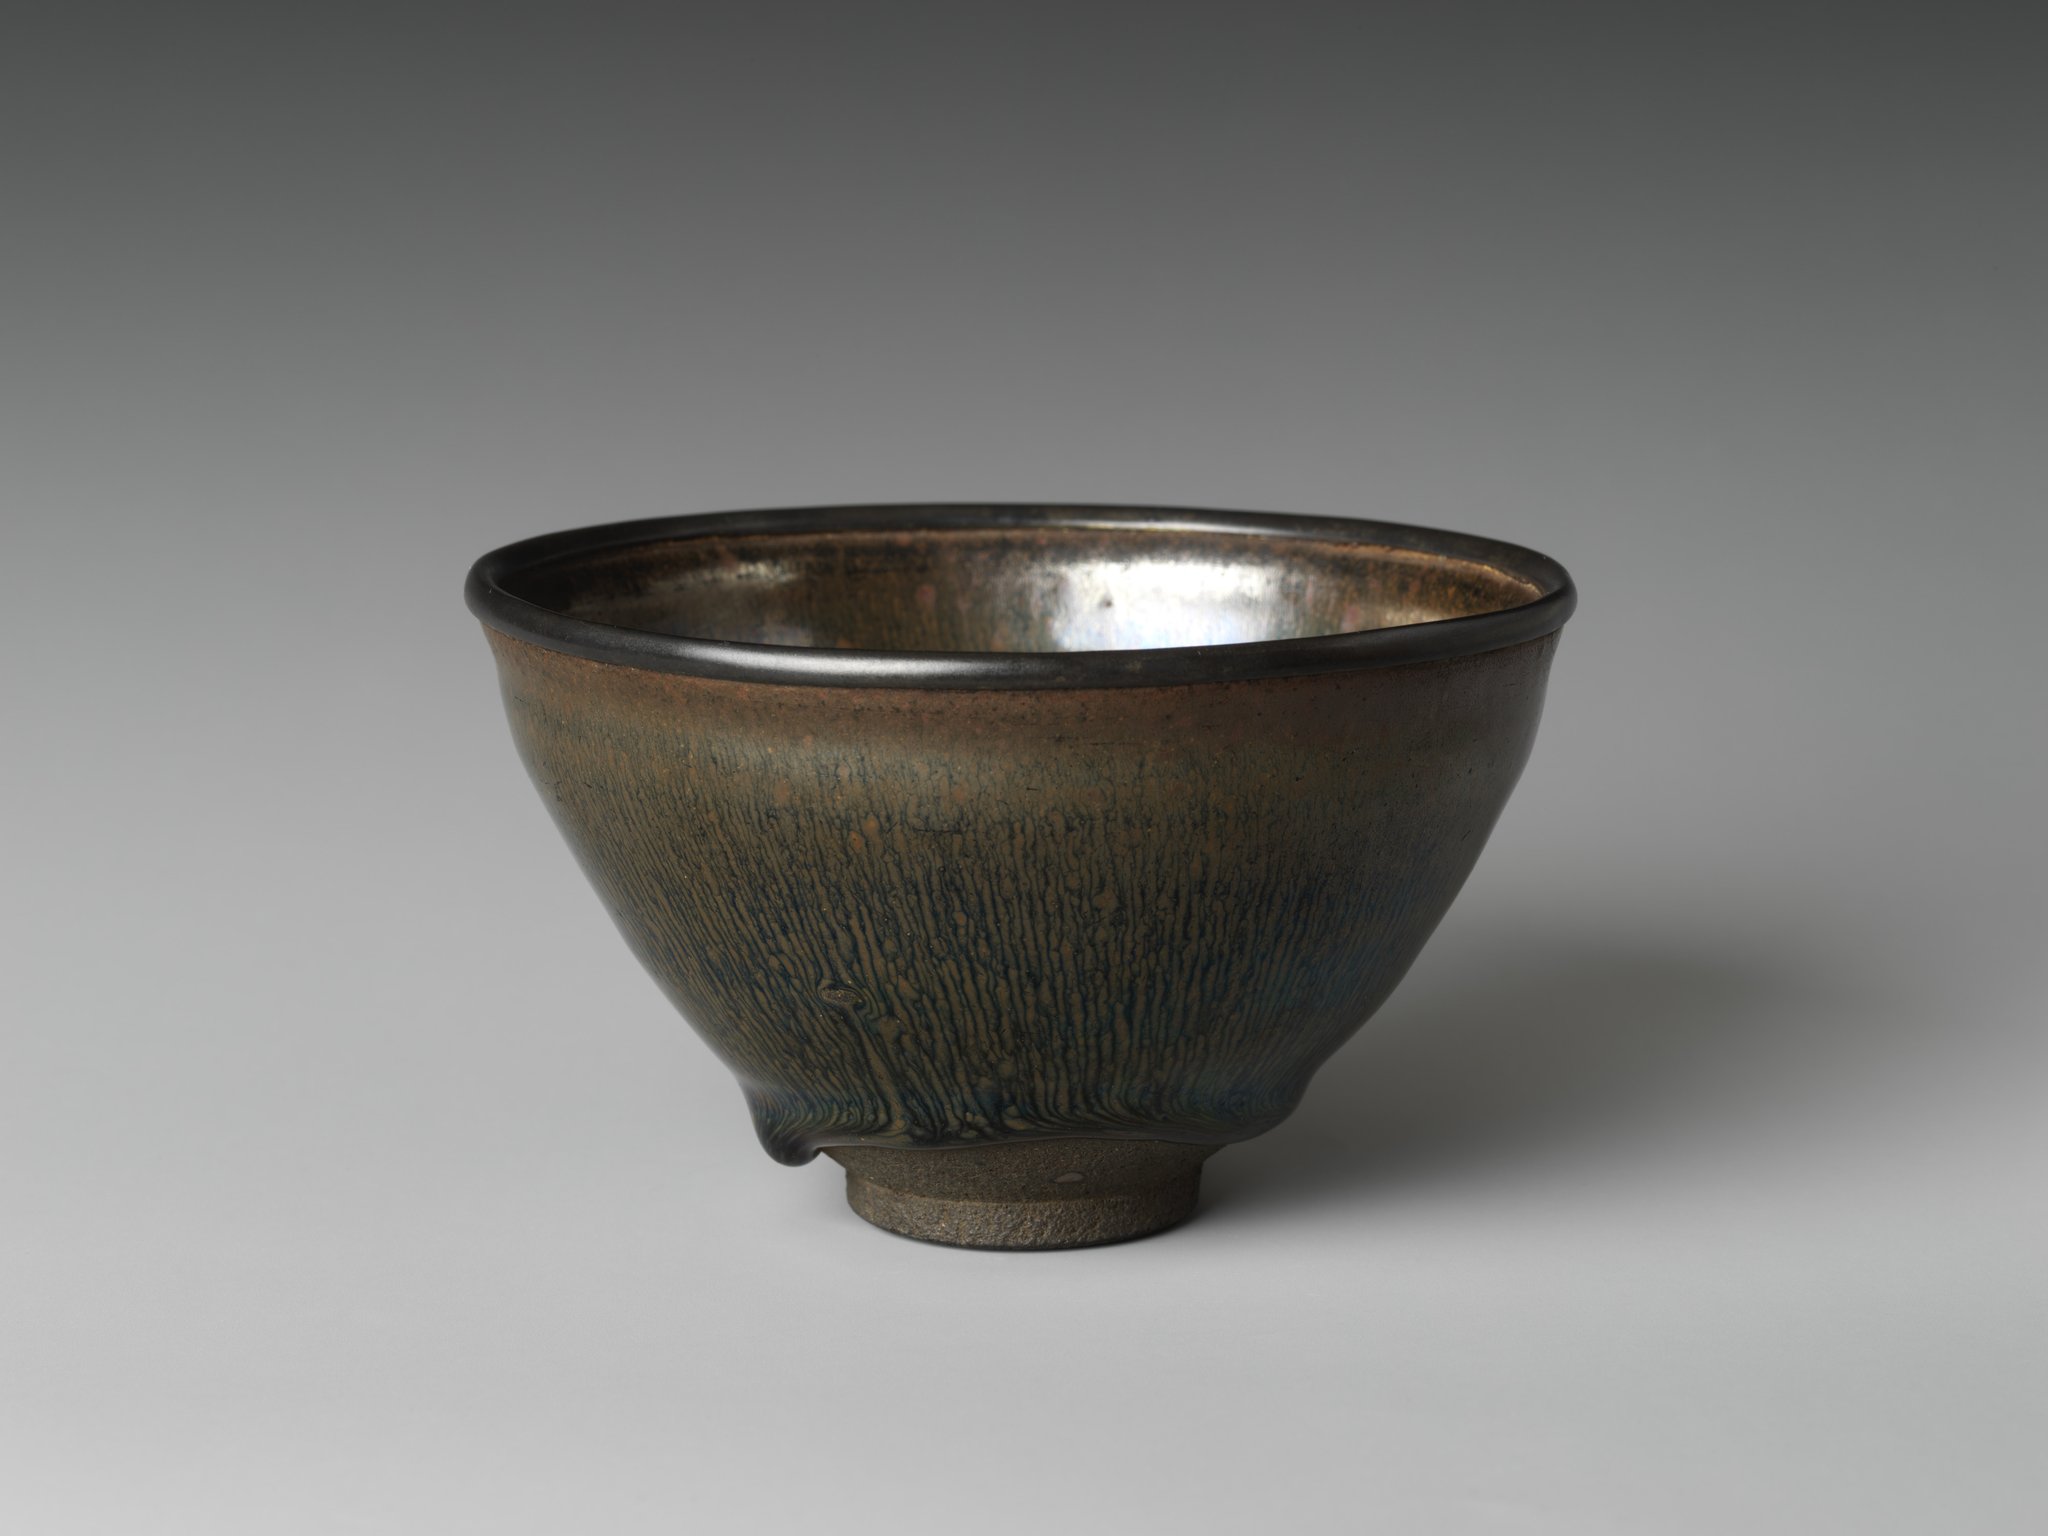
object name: bowl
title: Tenmoku Tea Bowl with Hare’s-Fur Glaze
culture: chinese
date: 1101-1200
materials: copper, glaze, stoneware